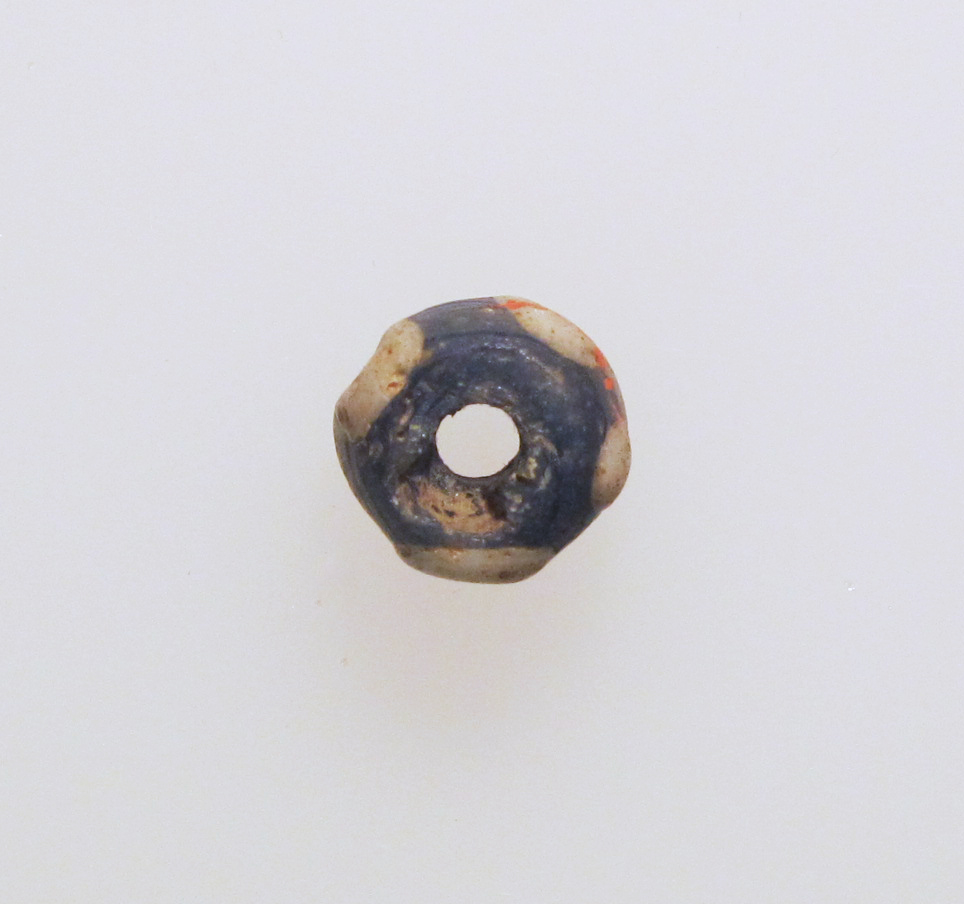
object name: bead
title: Glass bead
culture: roman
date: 101-400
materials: glass